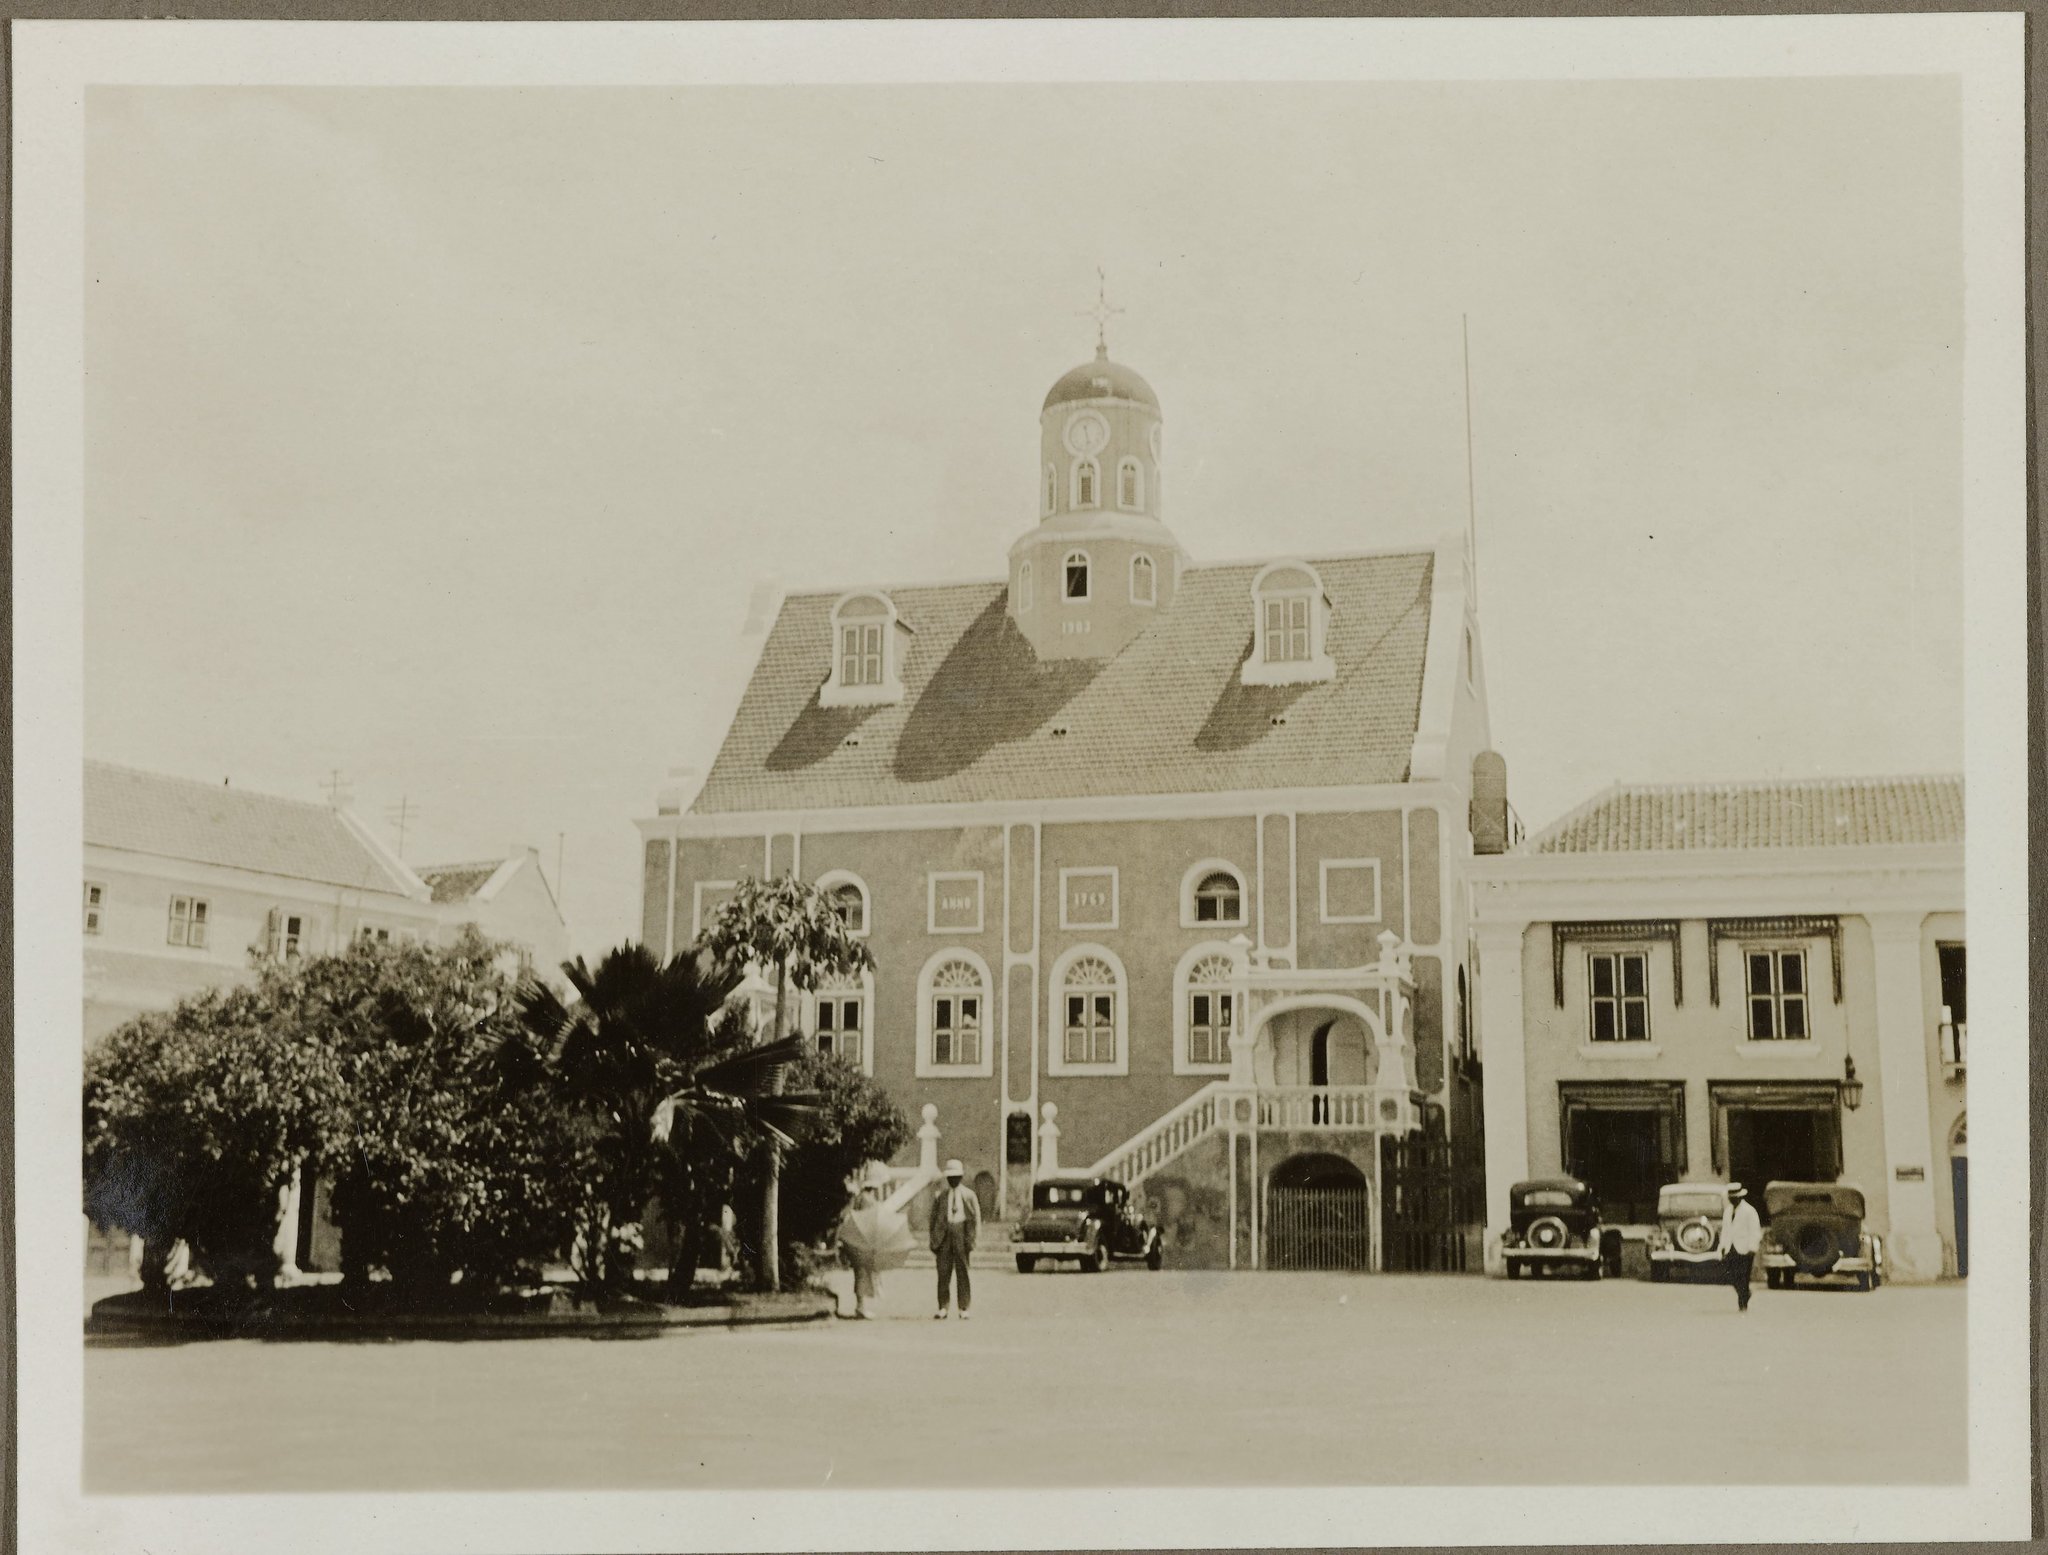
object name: photograph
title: Stadhuis te Willemstad, Curaçao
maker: Anonymous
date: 1925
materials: photographic support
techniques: photography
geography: curacao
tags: willemstad, fortkerk